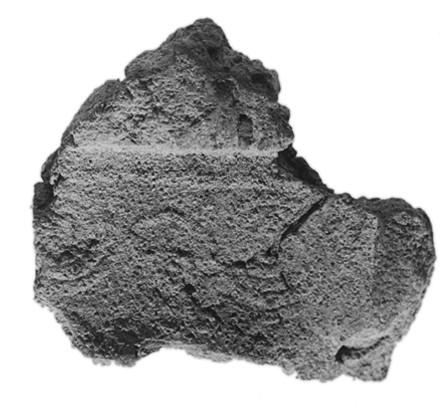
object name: sealing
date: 2030-1640 BCE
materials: clay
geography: egypt